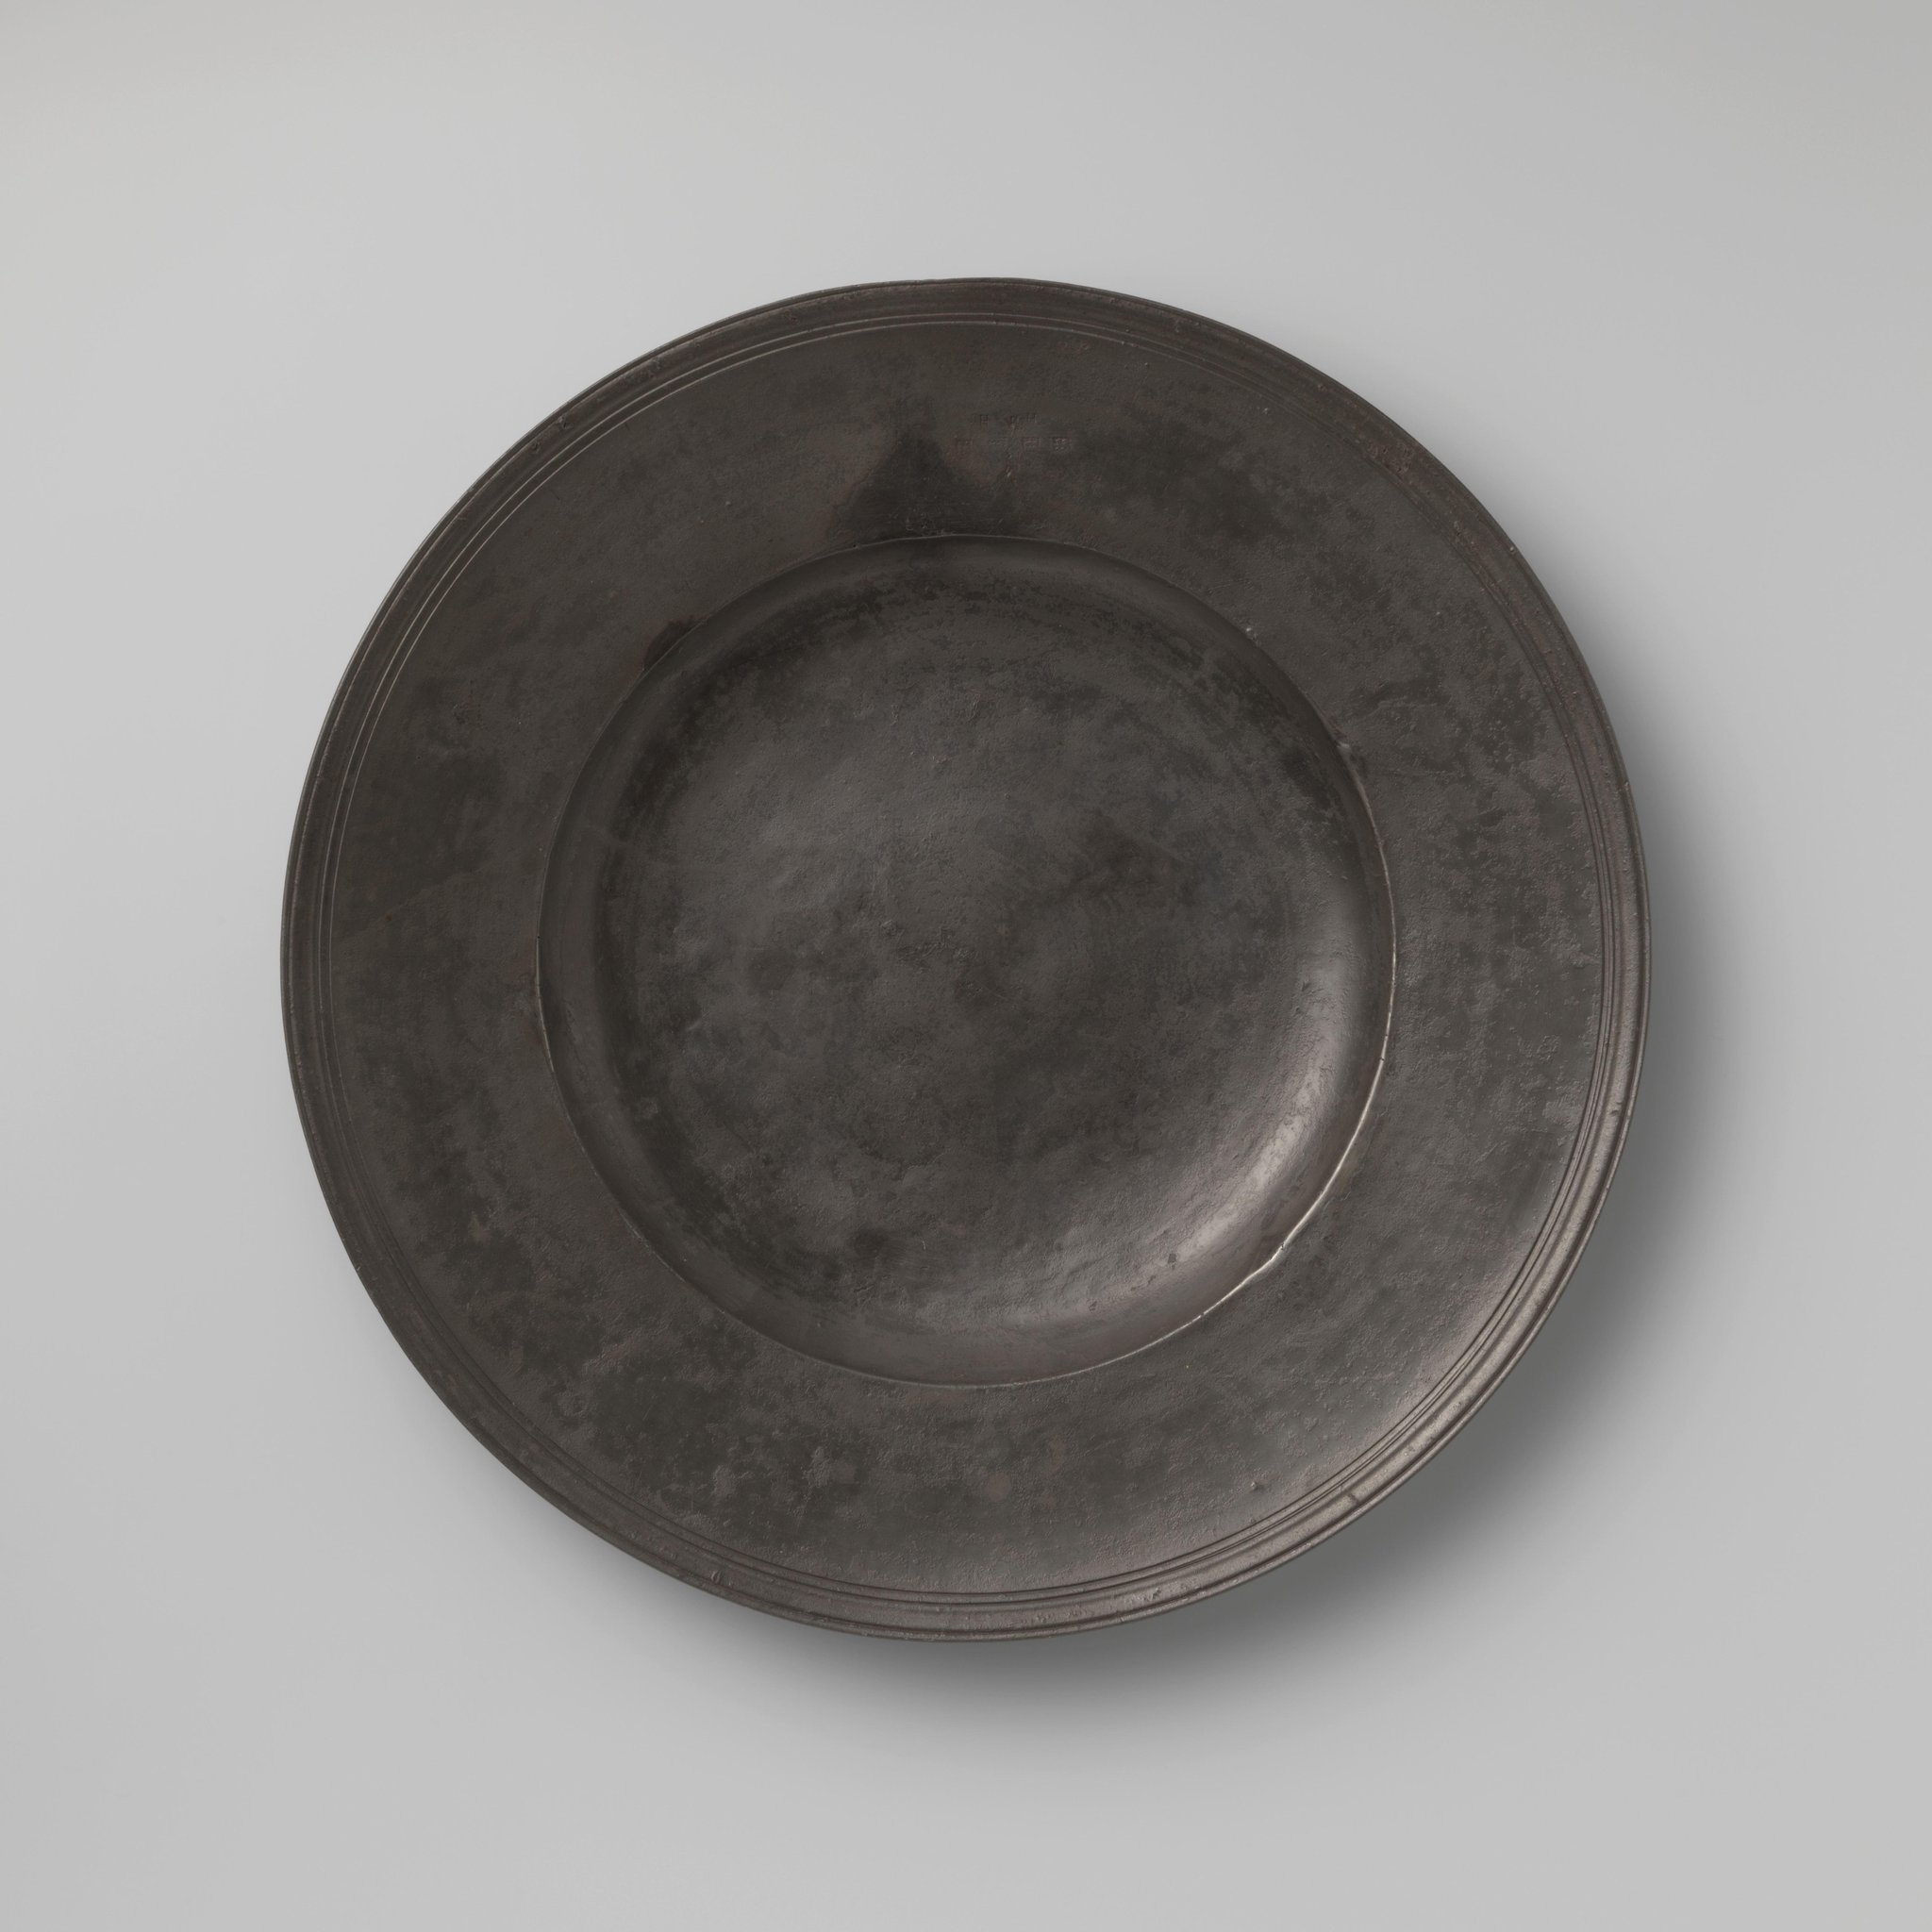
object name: platter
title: Schotel van tin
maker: Anonymous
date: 1700-1800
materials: tin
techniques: hammering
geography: great britain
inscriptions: inscription: ‘HVH’, quality mark, quality mark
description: Grote vlakke tinnen schotel, spiraal of schroefvormig gehamerd. Merktekens en de letters H H.